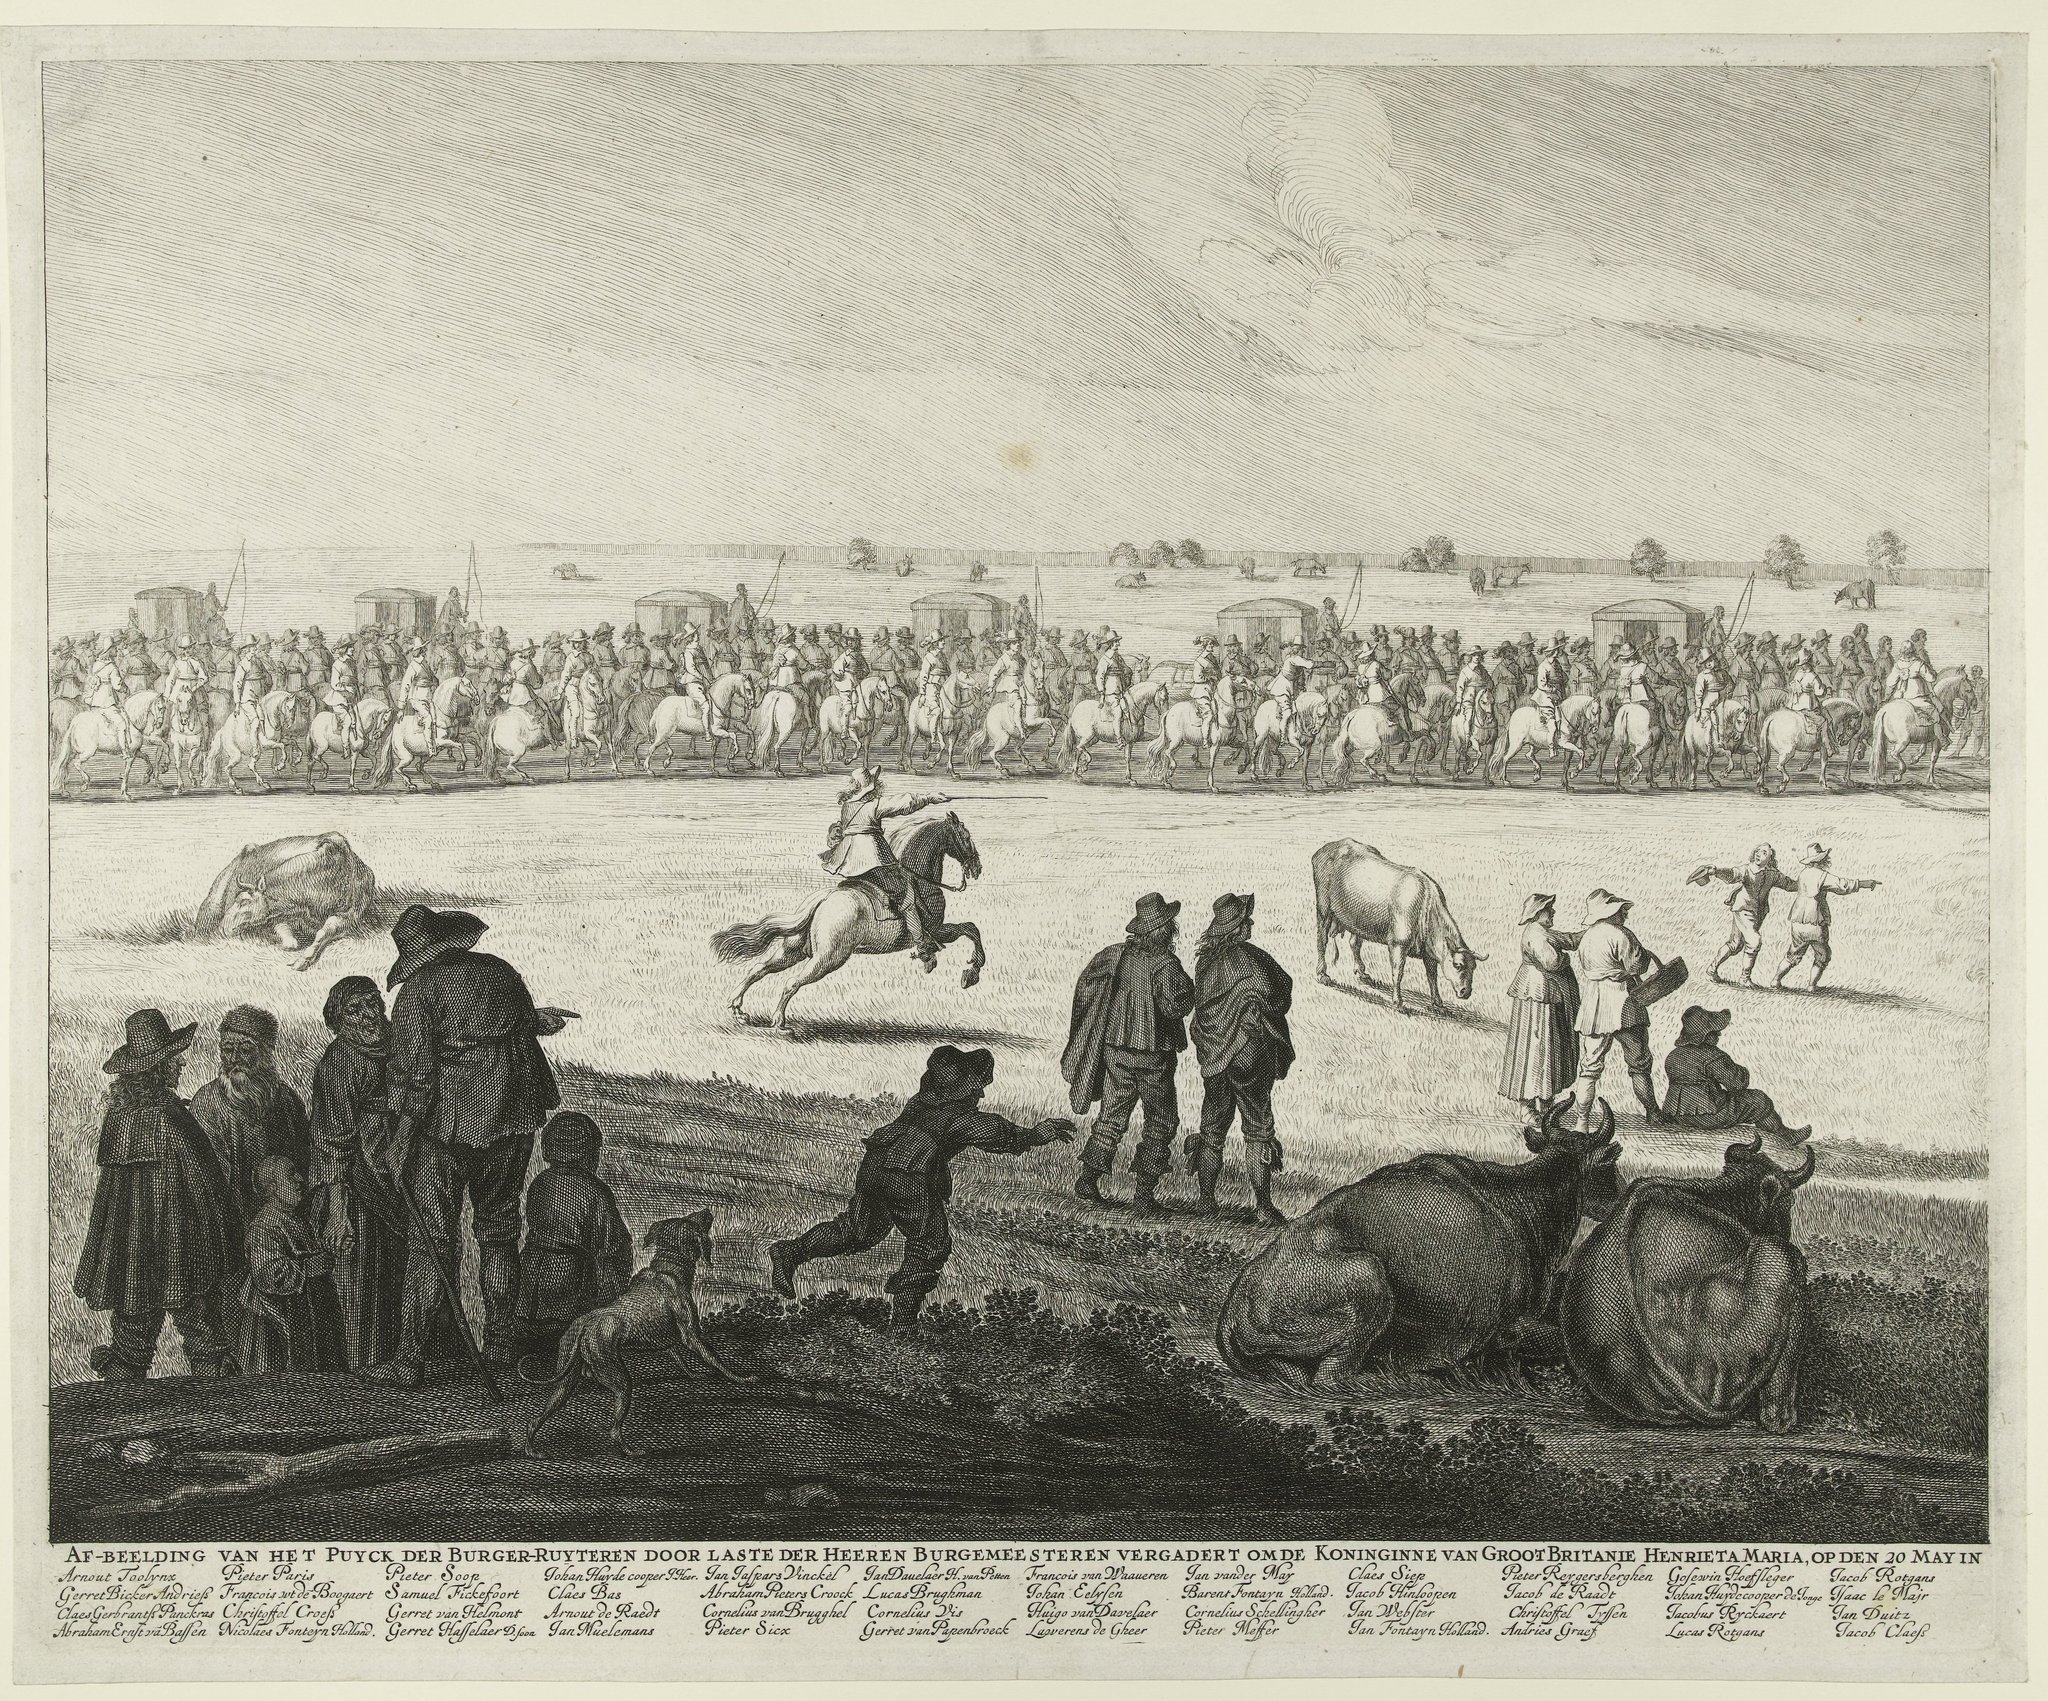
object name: print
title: Optocht van de schutters langs de Haarlemmertrekvaart bij de intocht van koningin Henrietta Maria te Amsterdam, 1642 (linkerblad)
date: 1642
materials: paper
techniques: etching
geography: northern netherlands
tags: henriëtta maria van frankrijk (koningin van engeland, schotland en ierland), triumphal entry and public reception, pageant, 'entrée solennelle', 'joyeuse entrée'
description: Optocht van de schutters langs de Haarlemmertrekvaart bij de intocht van Engelse koningin Henrietta Maria te Amsterdam, 20 mei 1642. Geheel bestaande uit drie bladen: linkerblad. De stoet van zes rijtuigen begeleid door ruiters. Op de voorgrond toeschouwers en vee. In het onderschrift het begin van de titel en een lijst in 12 kolommen met een deel van de namen van de ruiters in de stoet.